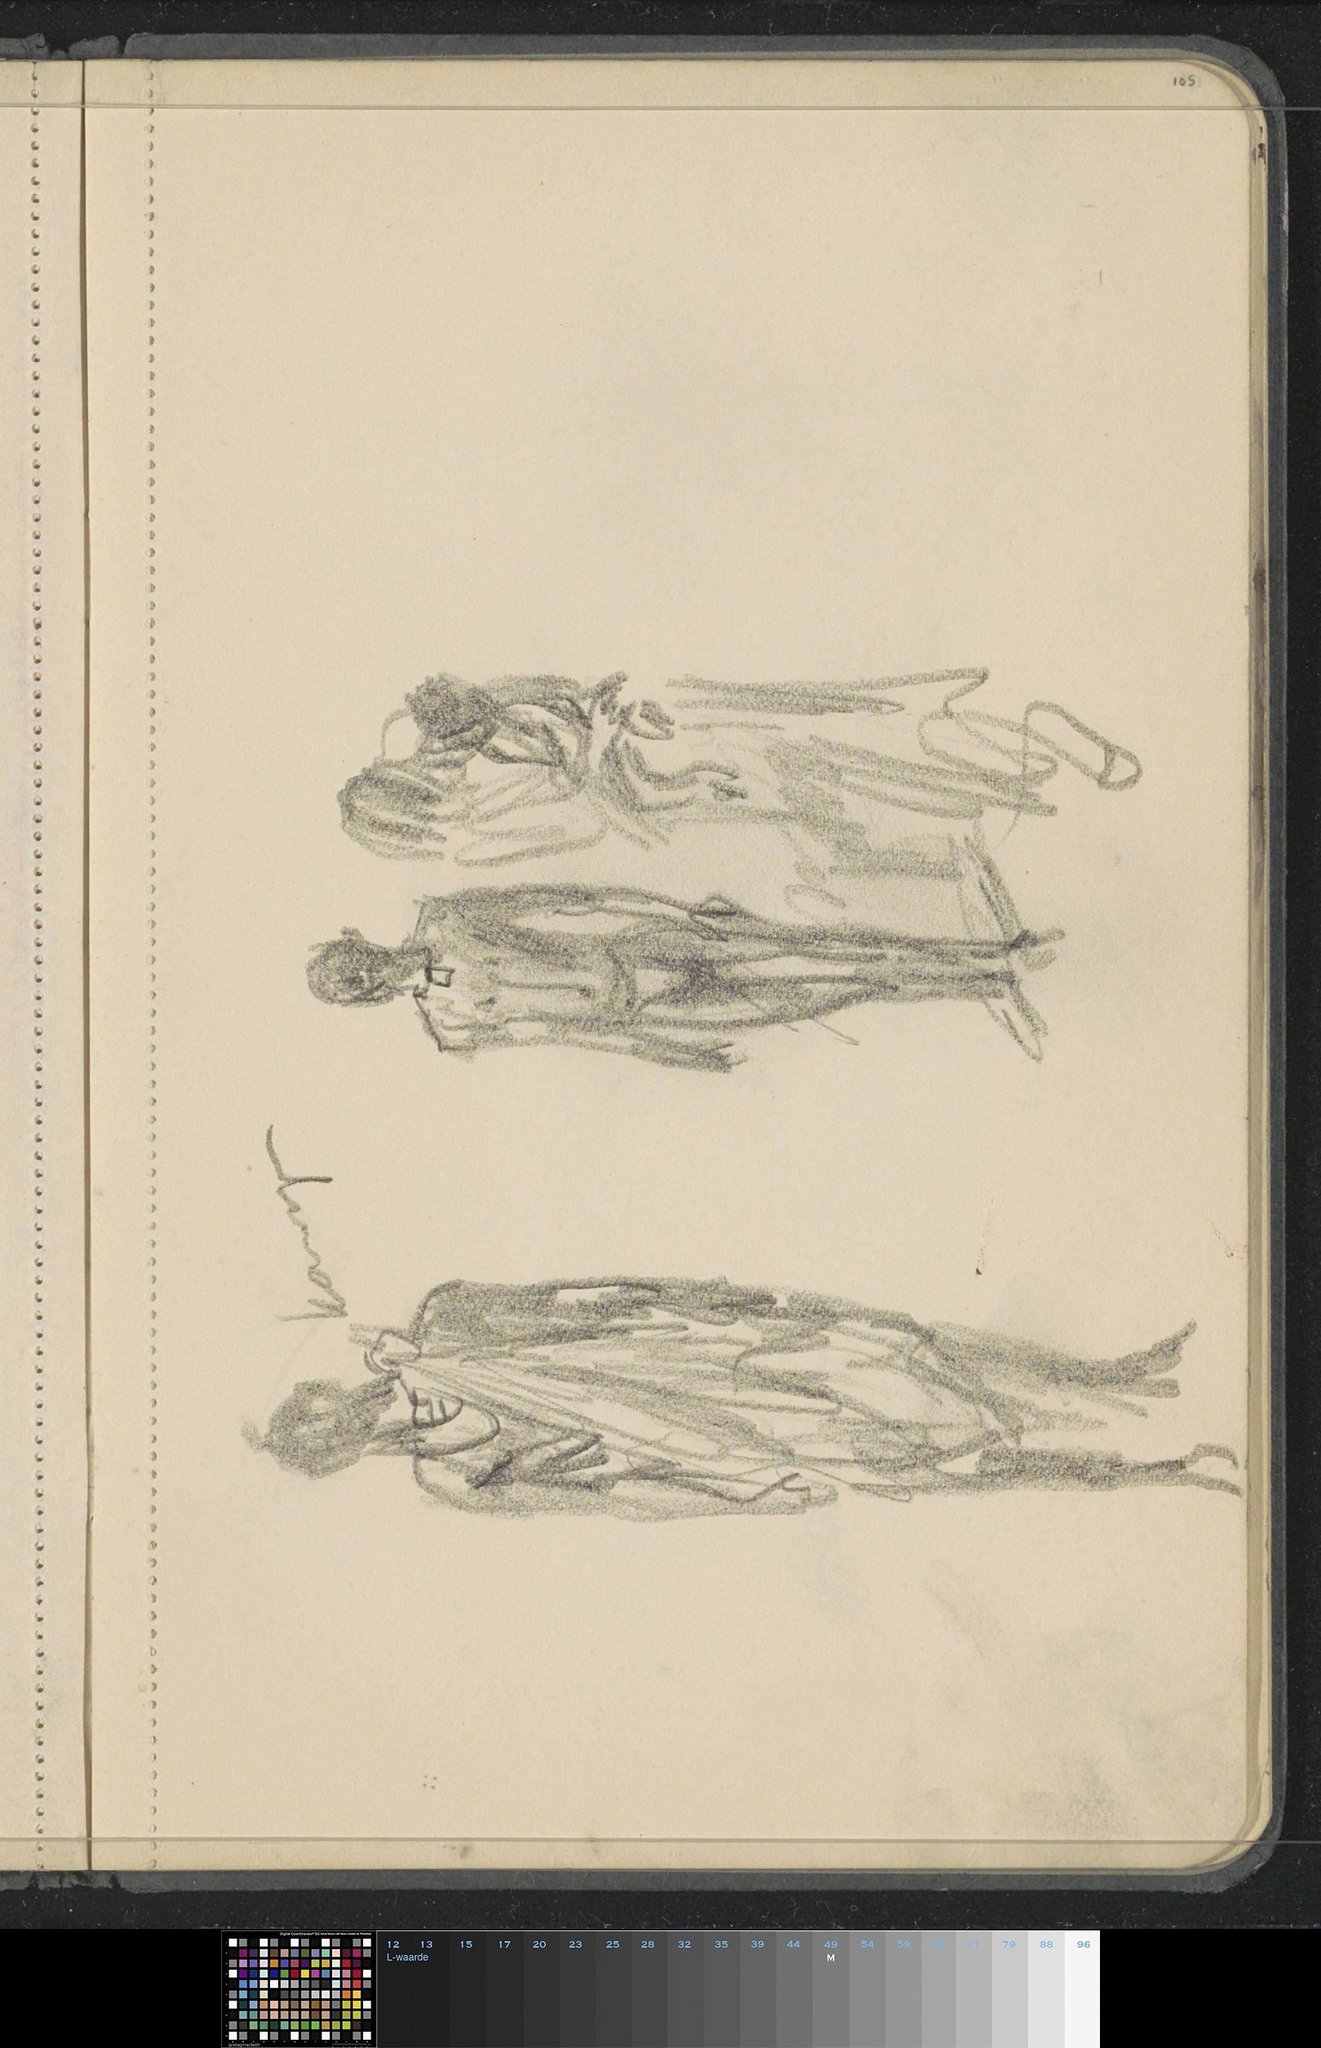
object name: sketchbook leaf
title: Indiërs, van voren gezien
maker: marius bauer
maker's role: draughtsman, print maker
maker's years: 1867-1932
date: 1924-1925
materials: paper, pencil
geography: india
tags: carrying a child on the hip, astride, folk costume, regional costume, asiatic races and peoples: indians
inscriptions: kleurnotitie, handgeschreven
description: Twee mannen en een vrouw met een kind op de heup. Pagina 105 uit een schetsboek met 87 bladen.